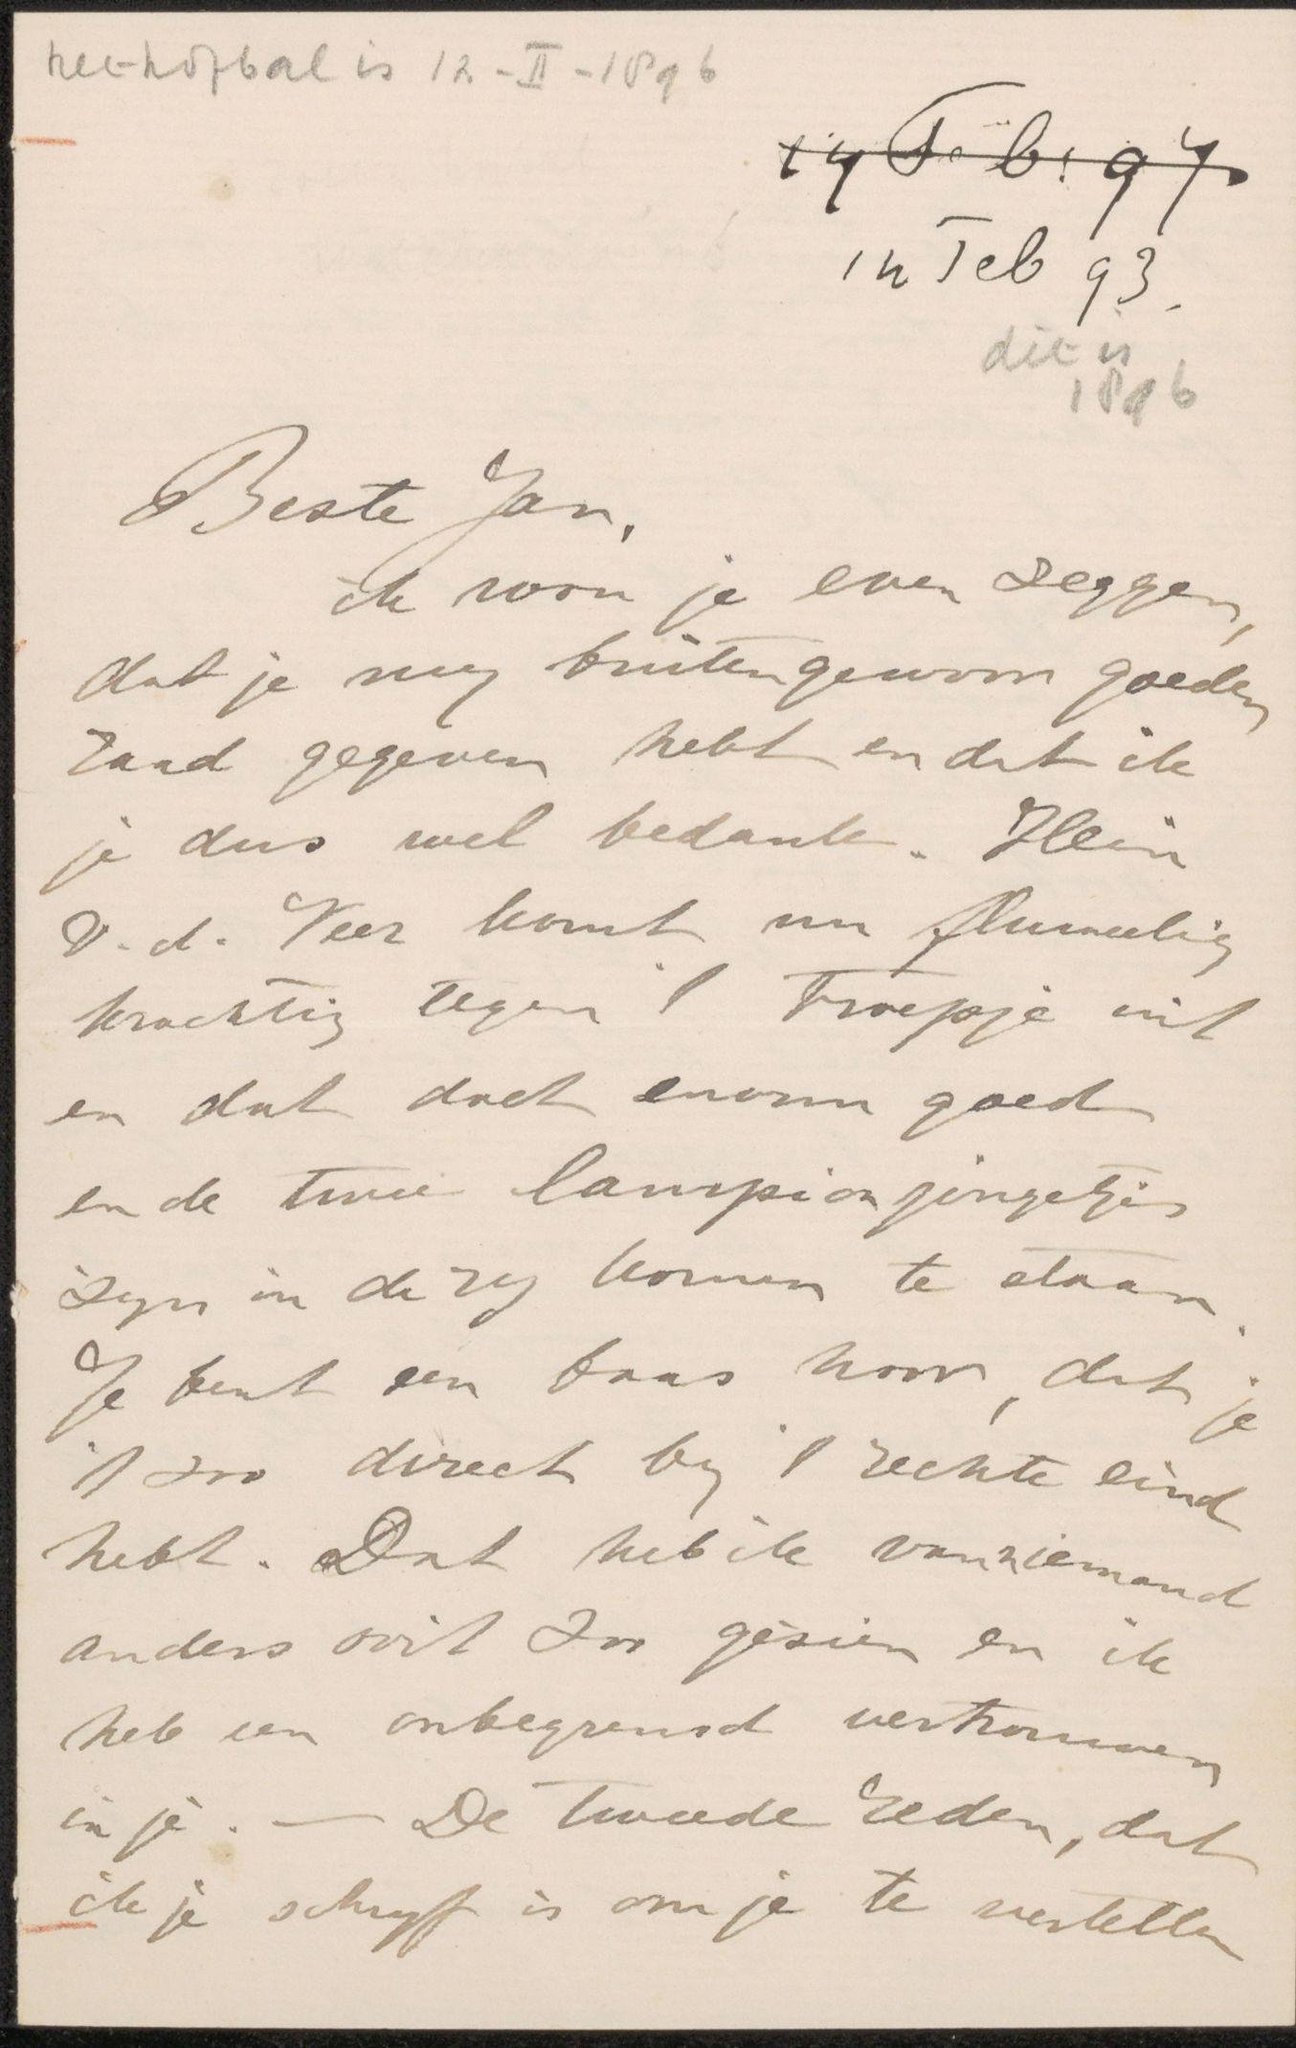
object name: letter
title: Brief aan Jan Veth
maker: wally moes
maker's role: draughtsman, print maker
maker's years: 1856-1918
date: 1874-1918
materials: ink, paper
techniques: pen, writing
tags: designer, jan veth, paris, victor hugo, painter, cornelis gerardus 't hooft, andré jolles, jacob pieter moltzer, historical persons (portraits and scenes from the life)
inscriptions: collector's mark: ‘RPK’, watermark